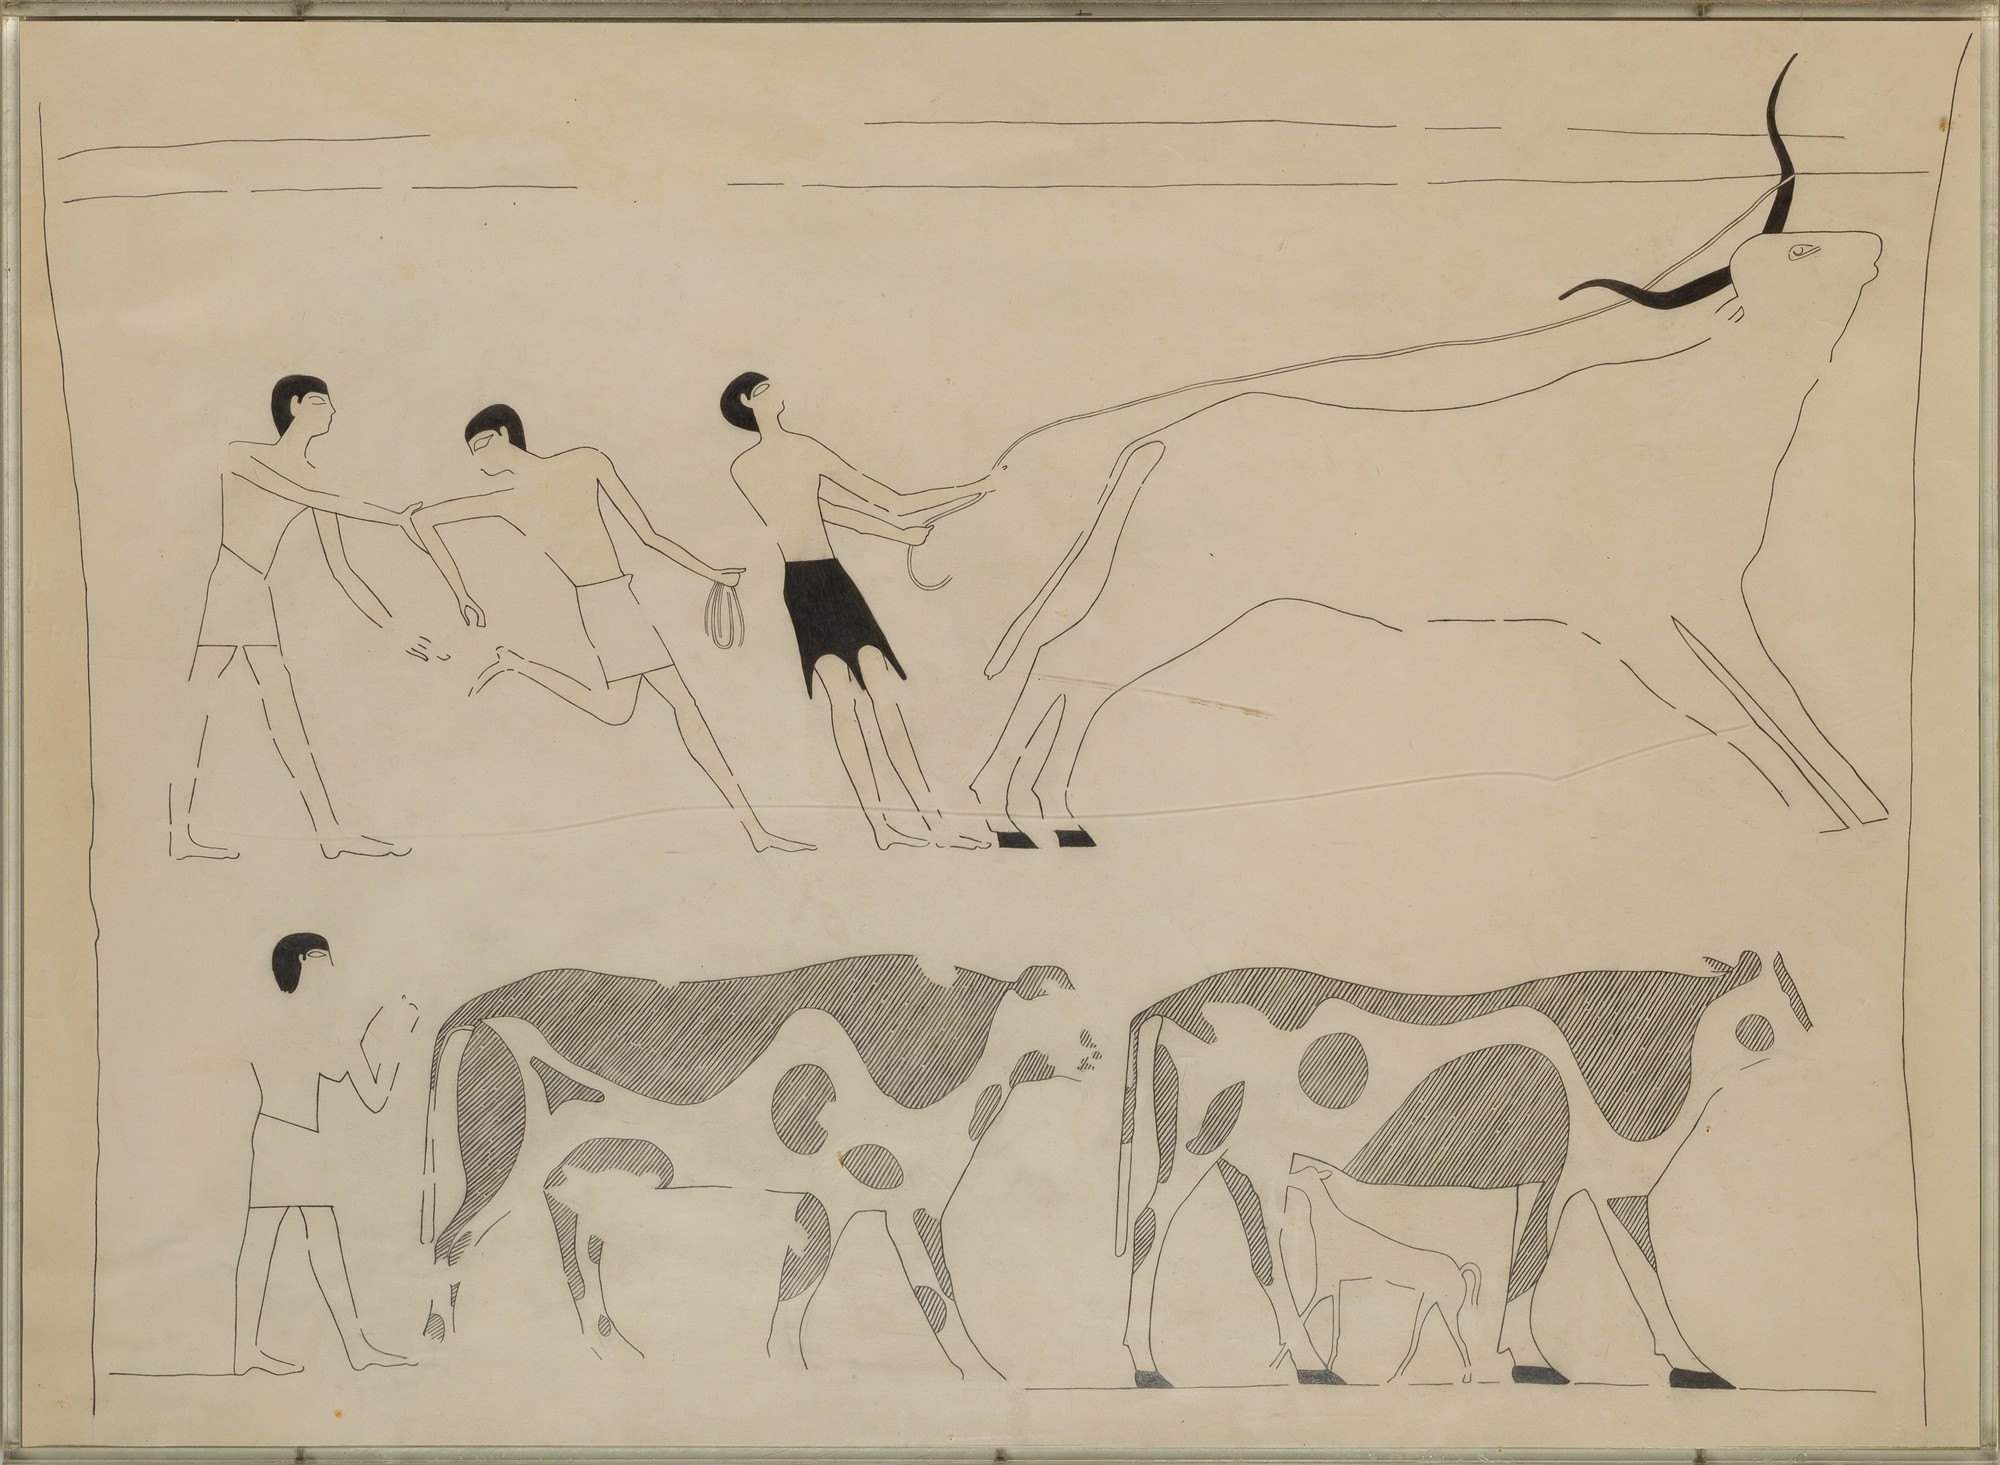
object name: facsimile, djari tt 366, bull roping, cattle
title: Men Roping a Bull and Driving Cattle, Tomb of Djari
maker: unknown copyist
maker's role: artist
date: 2050-2000 BCE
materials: ink, paper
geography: egypt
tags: men,bulls,cows